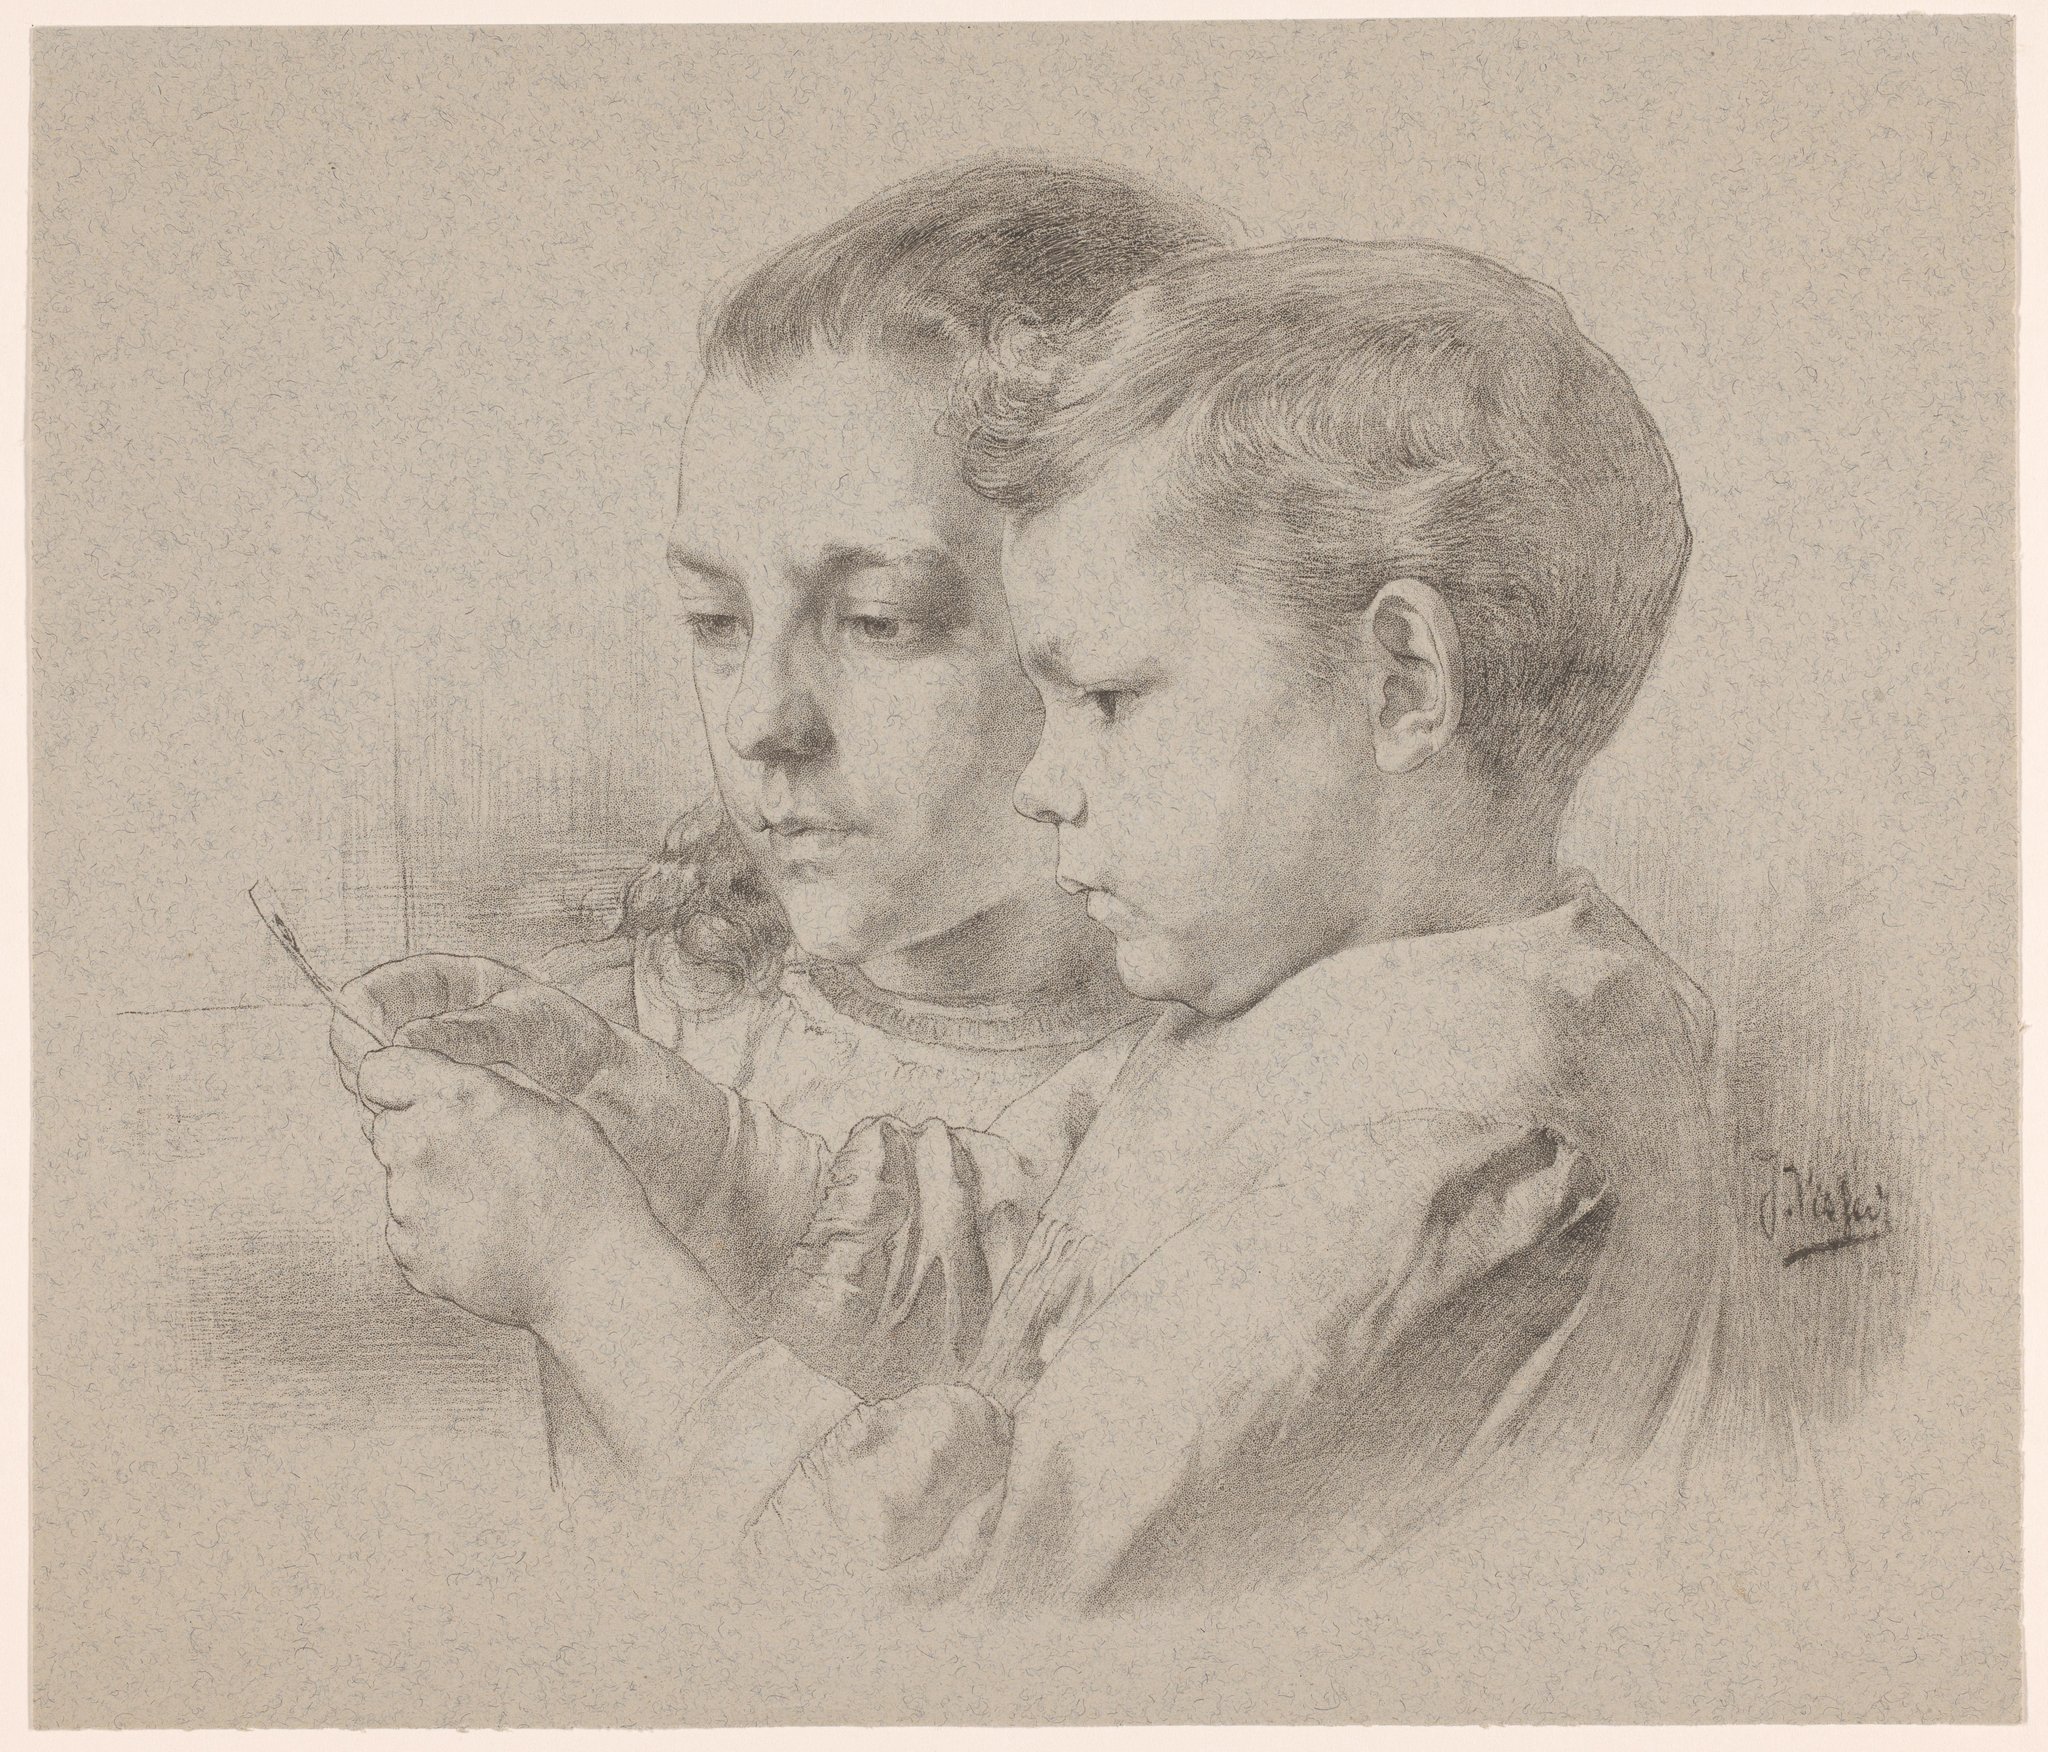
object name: print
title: Meisje en jongen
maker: jan visser (1856-1938)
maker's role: print maker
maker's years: 1856-1938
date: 1895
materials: paper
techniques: lithograph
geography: netherlands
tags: amsterdam, boy (child between toddler and youth)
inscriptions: collector's mark: Lugt 2228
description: Portret van Margaretha Anna en Karel Antoon Visser, dochter en zoon van de kunstenaar.